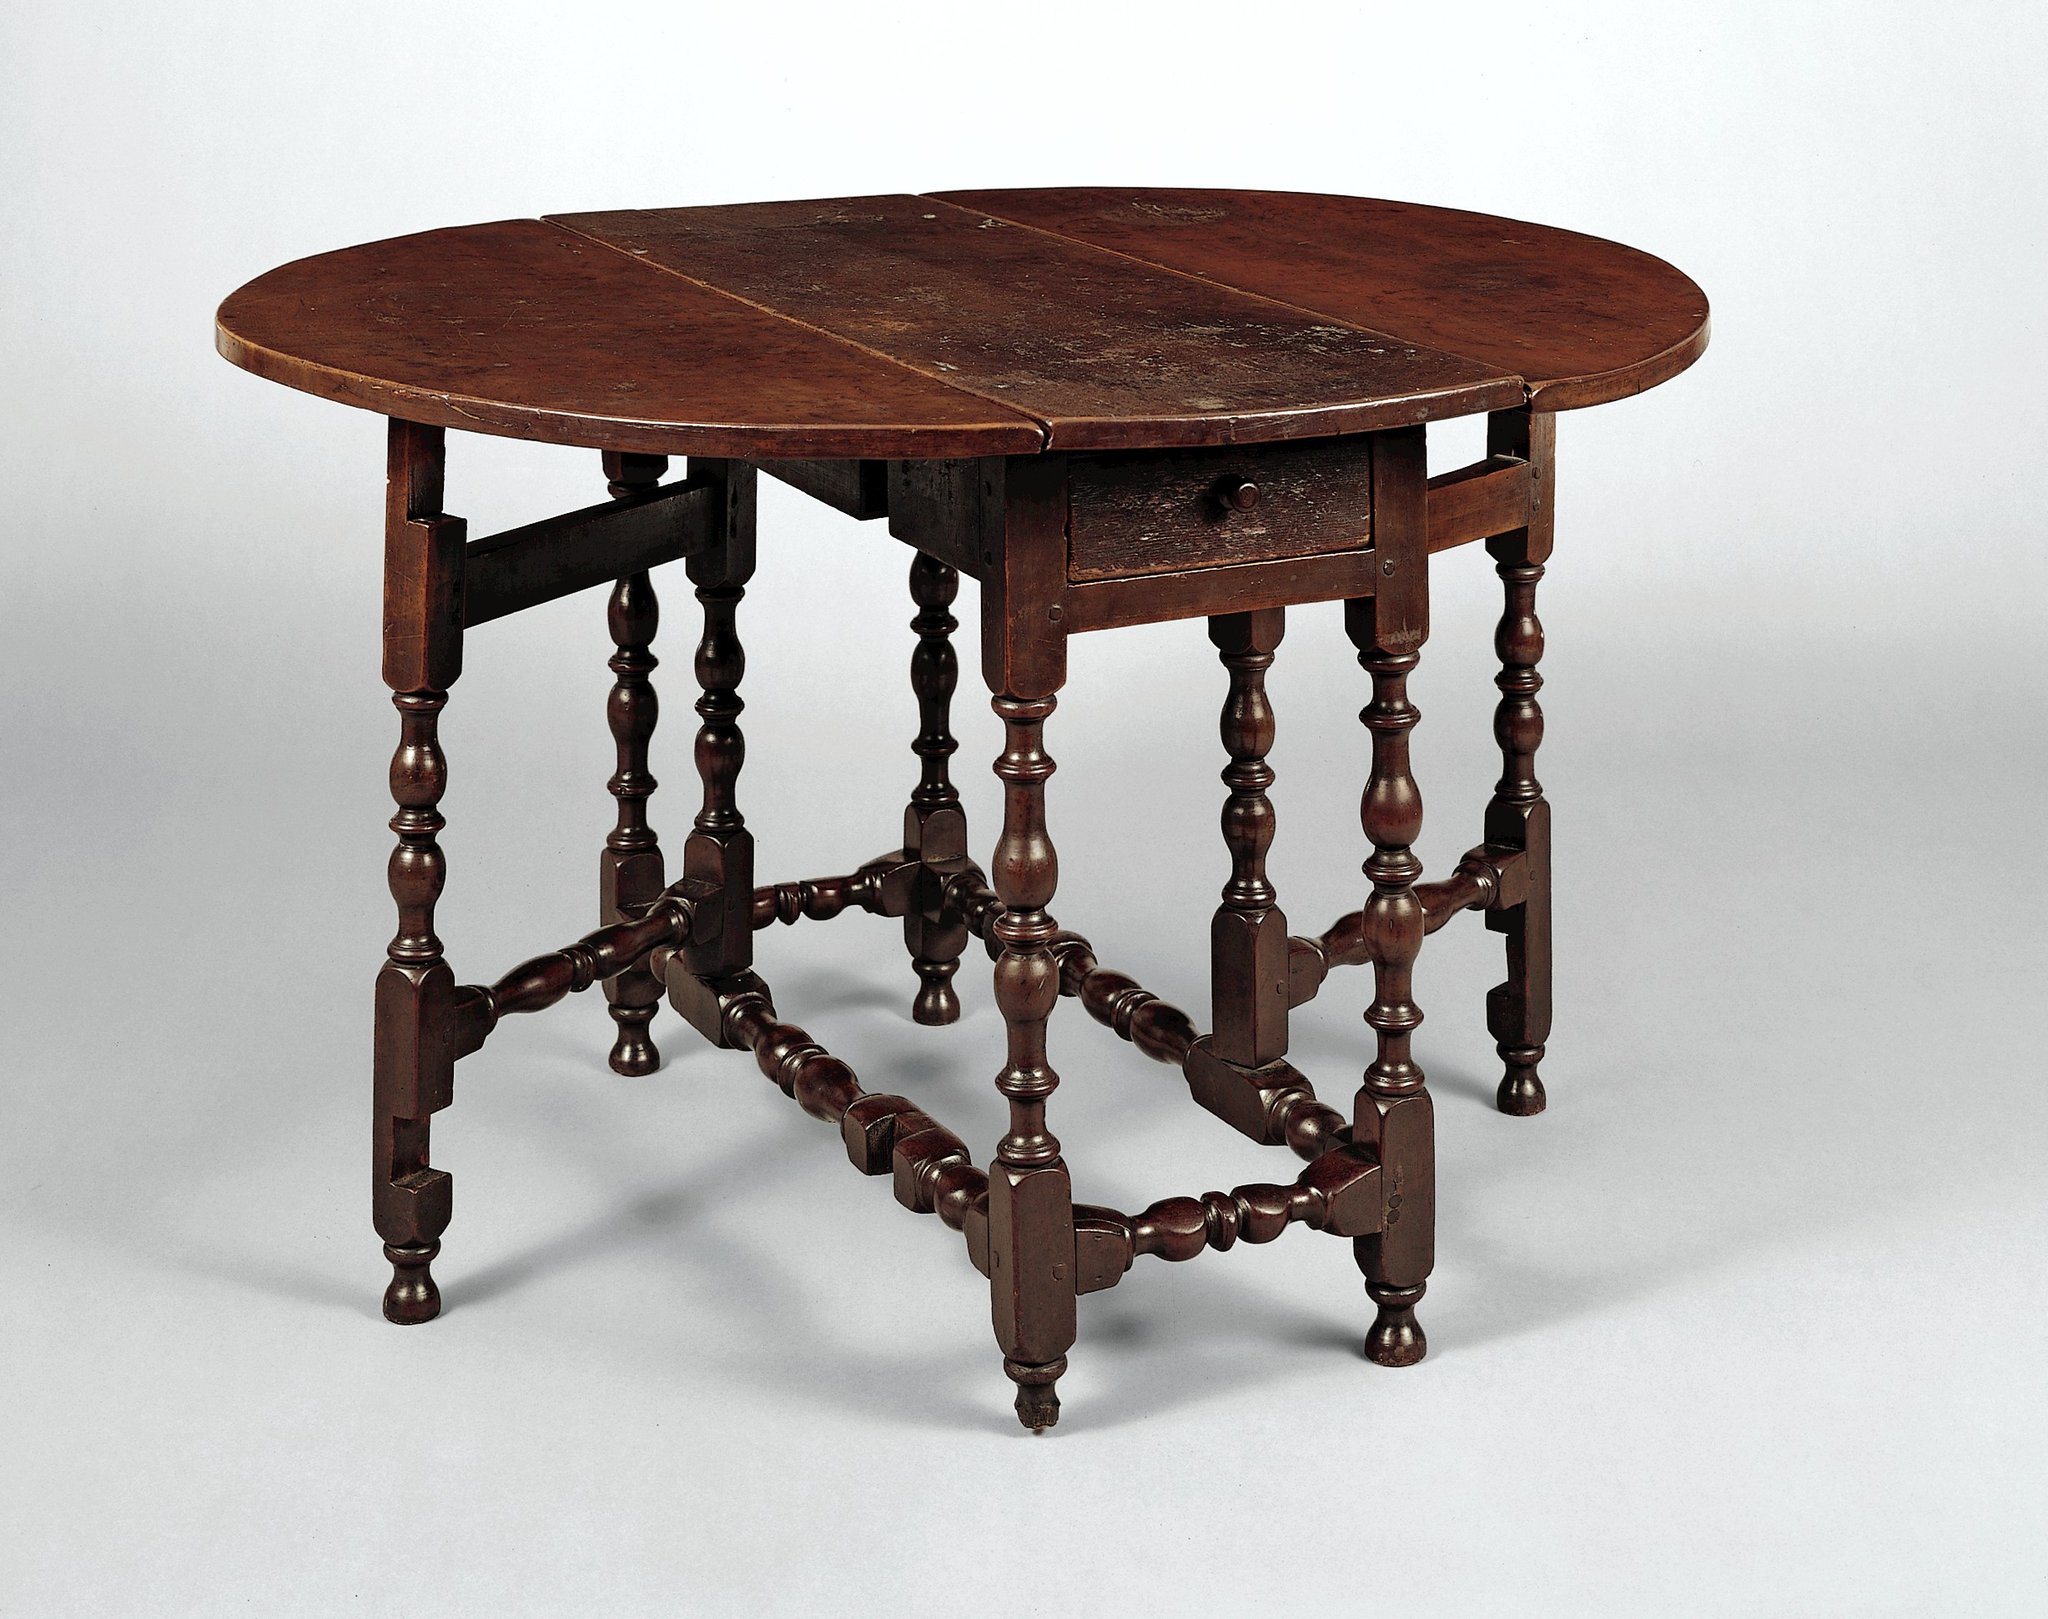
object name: drop leaf table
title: Drop-leaf Table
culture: american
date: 1700-1730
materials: wood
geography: united states